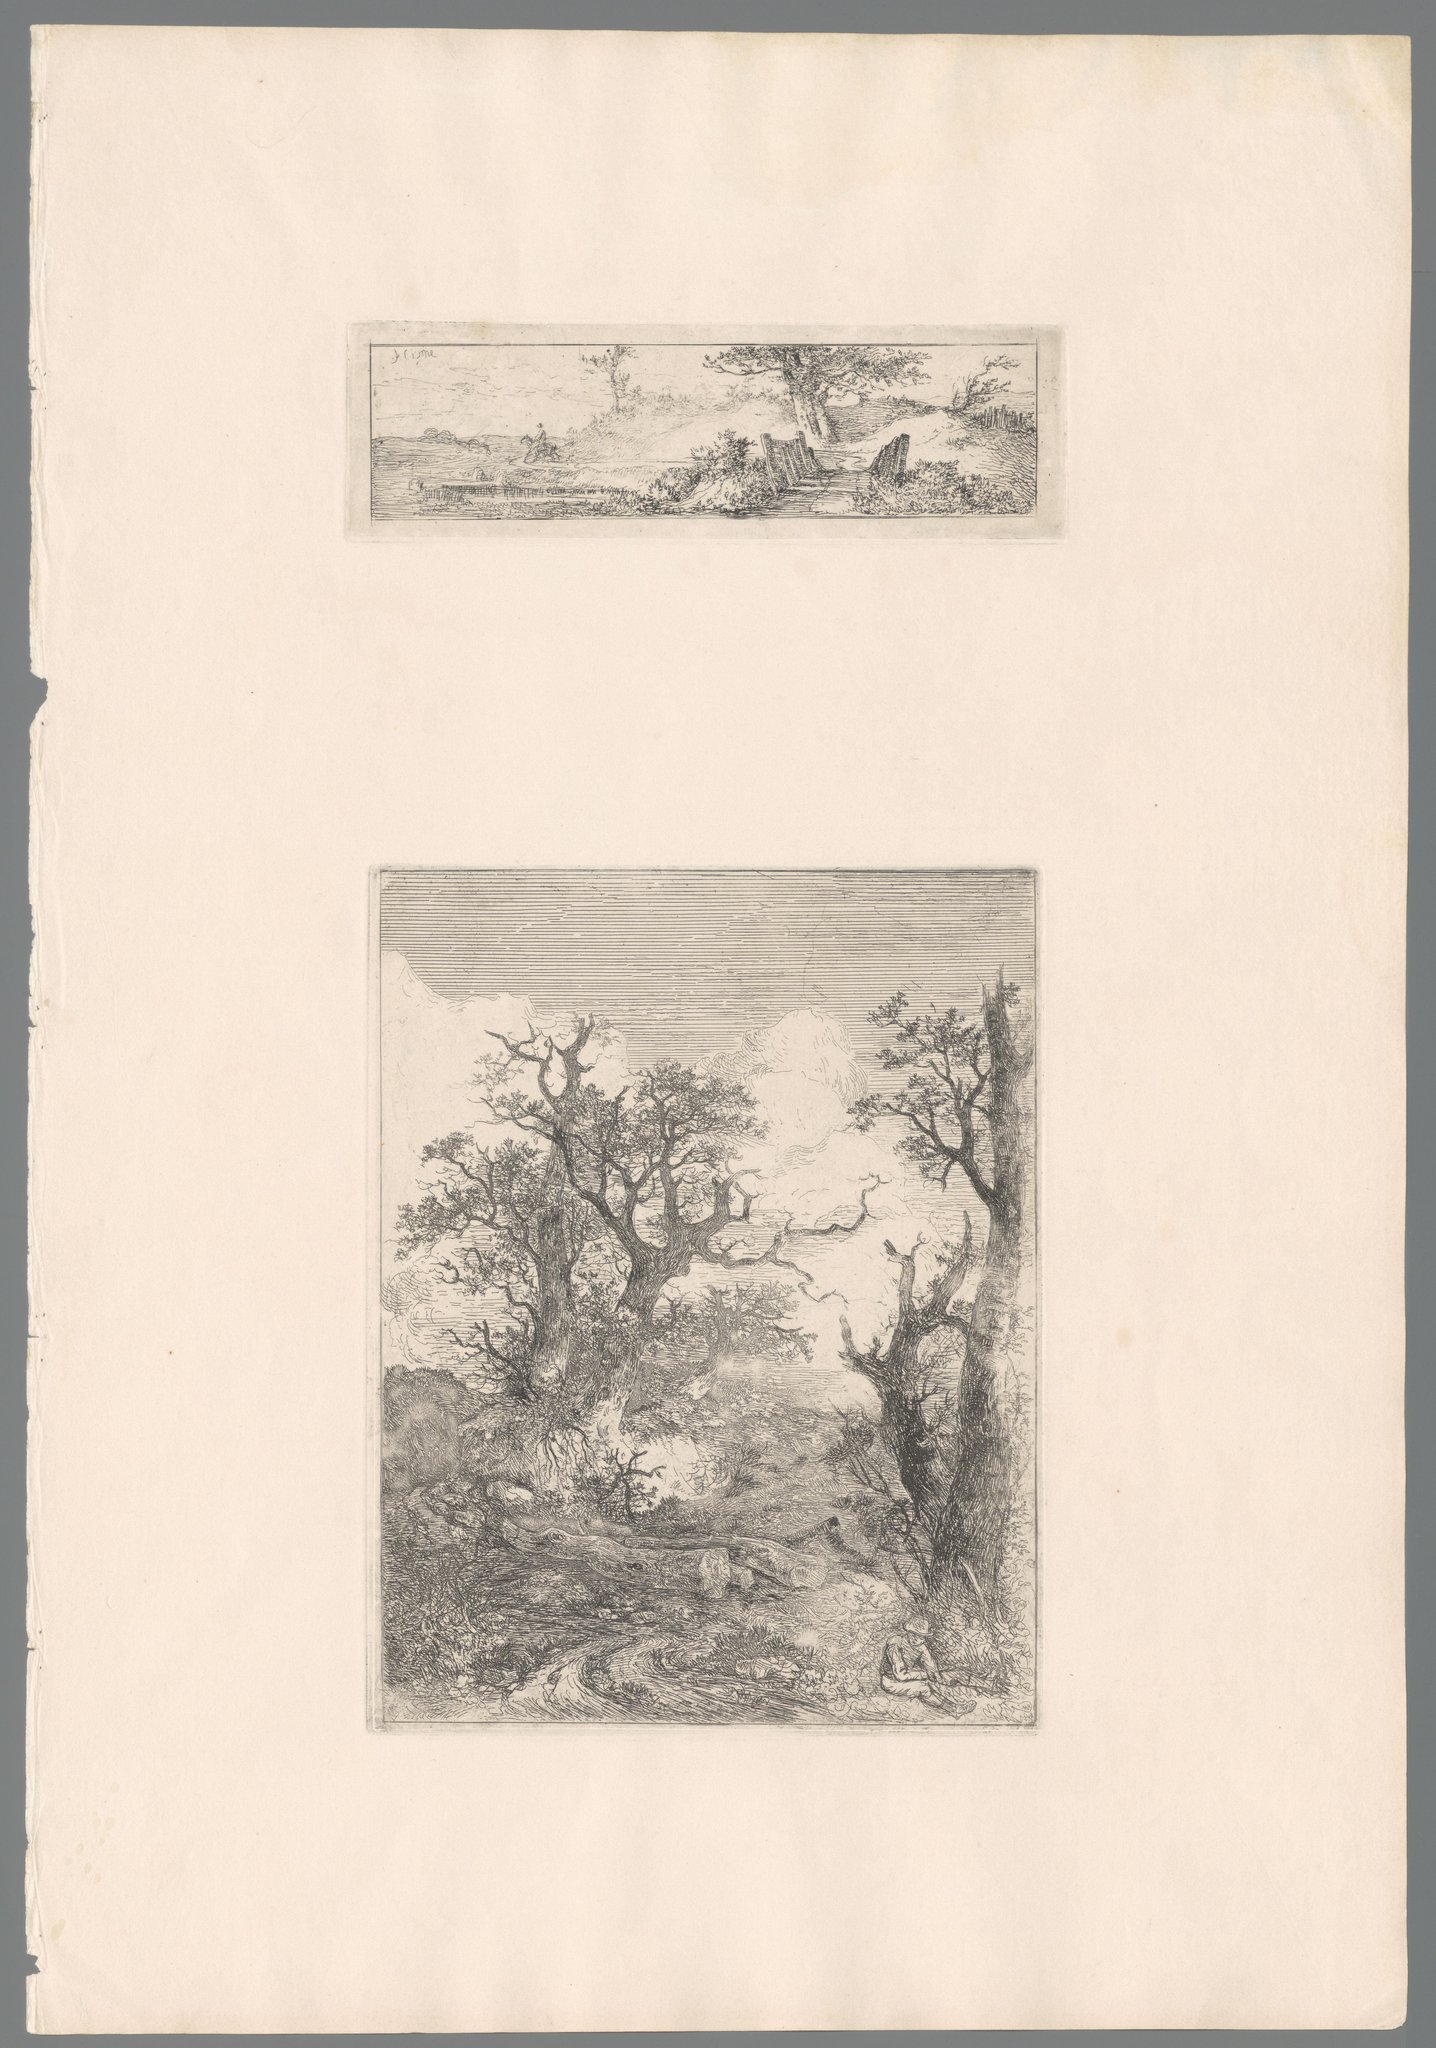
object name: print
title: Gravel Pit, Marlingford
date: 1834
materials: paper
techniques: etching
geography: norwich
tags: trees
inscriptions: collector's mark: Lugt 2228, collector's mark: Lugt 2760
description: Prent staat samen met RP-P-1973-178 op een onversneden blad.